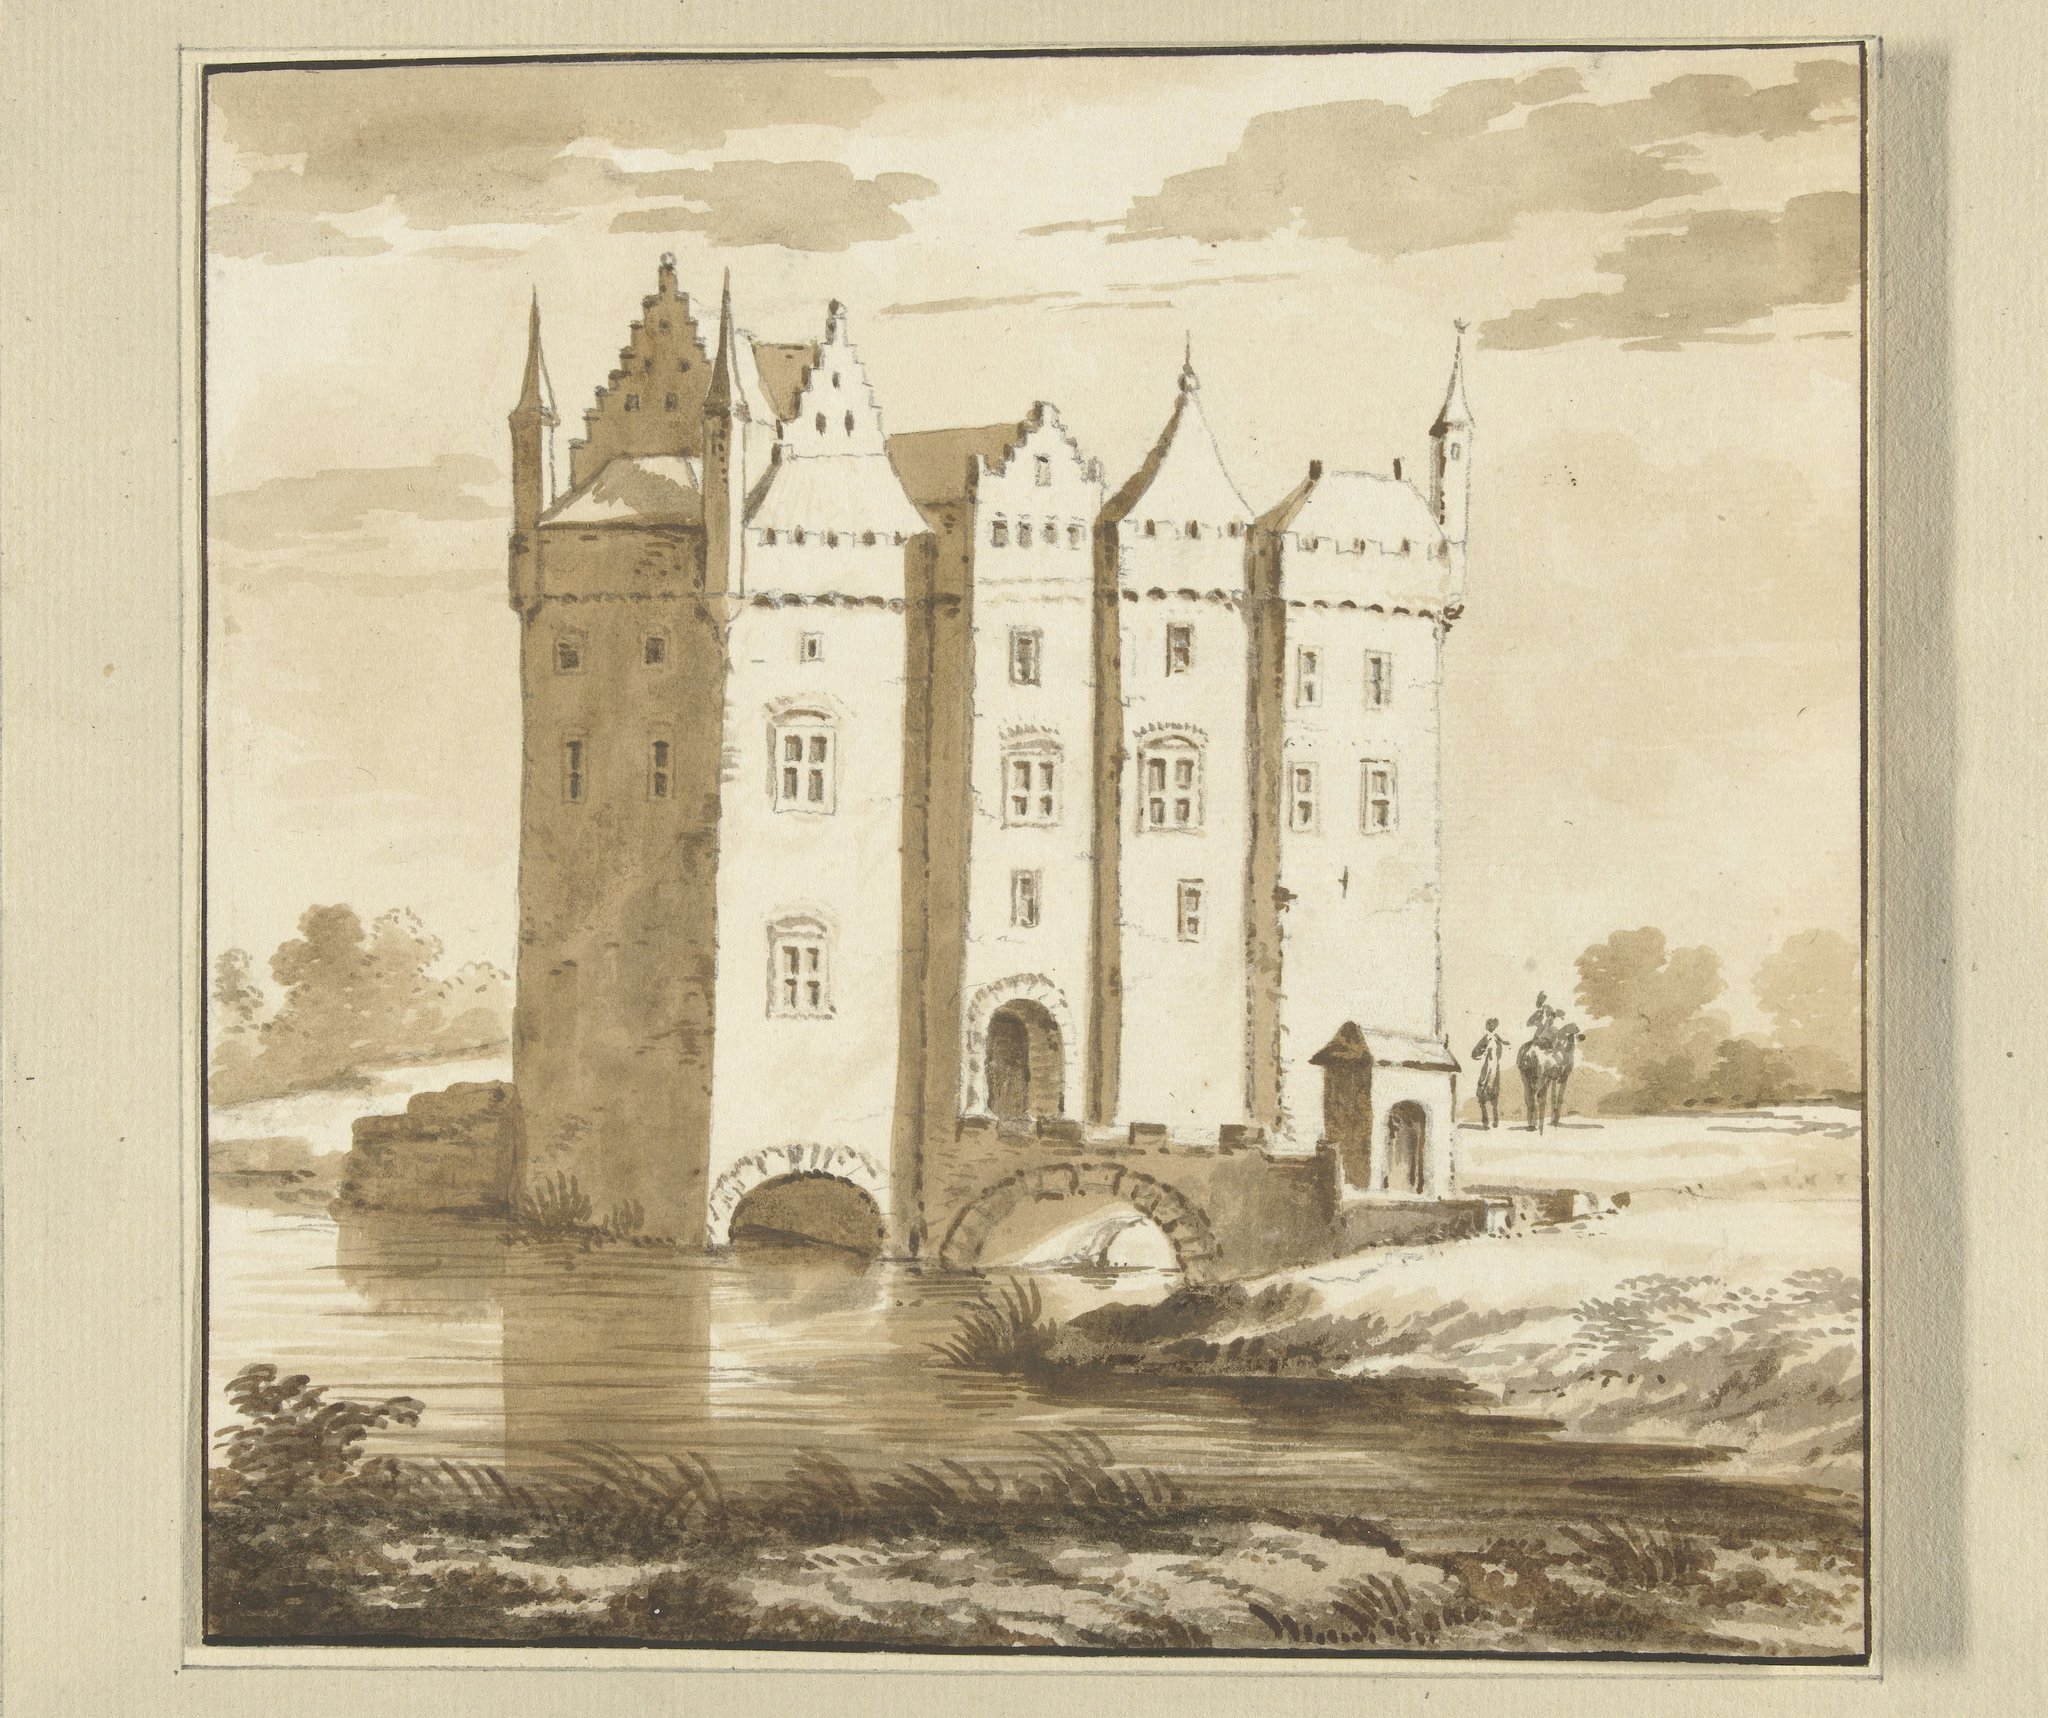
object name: drawing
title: Huis Duinhoven bij Oostkapelle in Walcheren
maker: abraham rademaker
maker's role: draughtsman, print maker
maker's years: 1676-1735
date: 1685-1735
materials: paper, pencil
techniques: brush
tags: castle